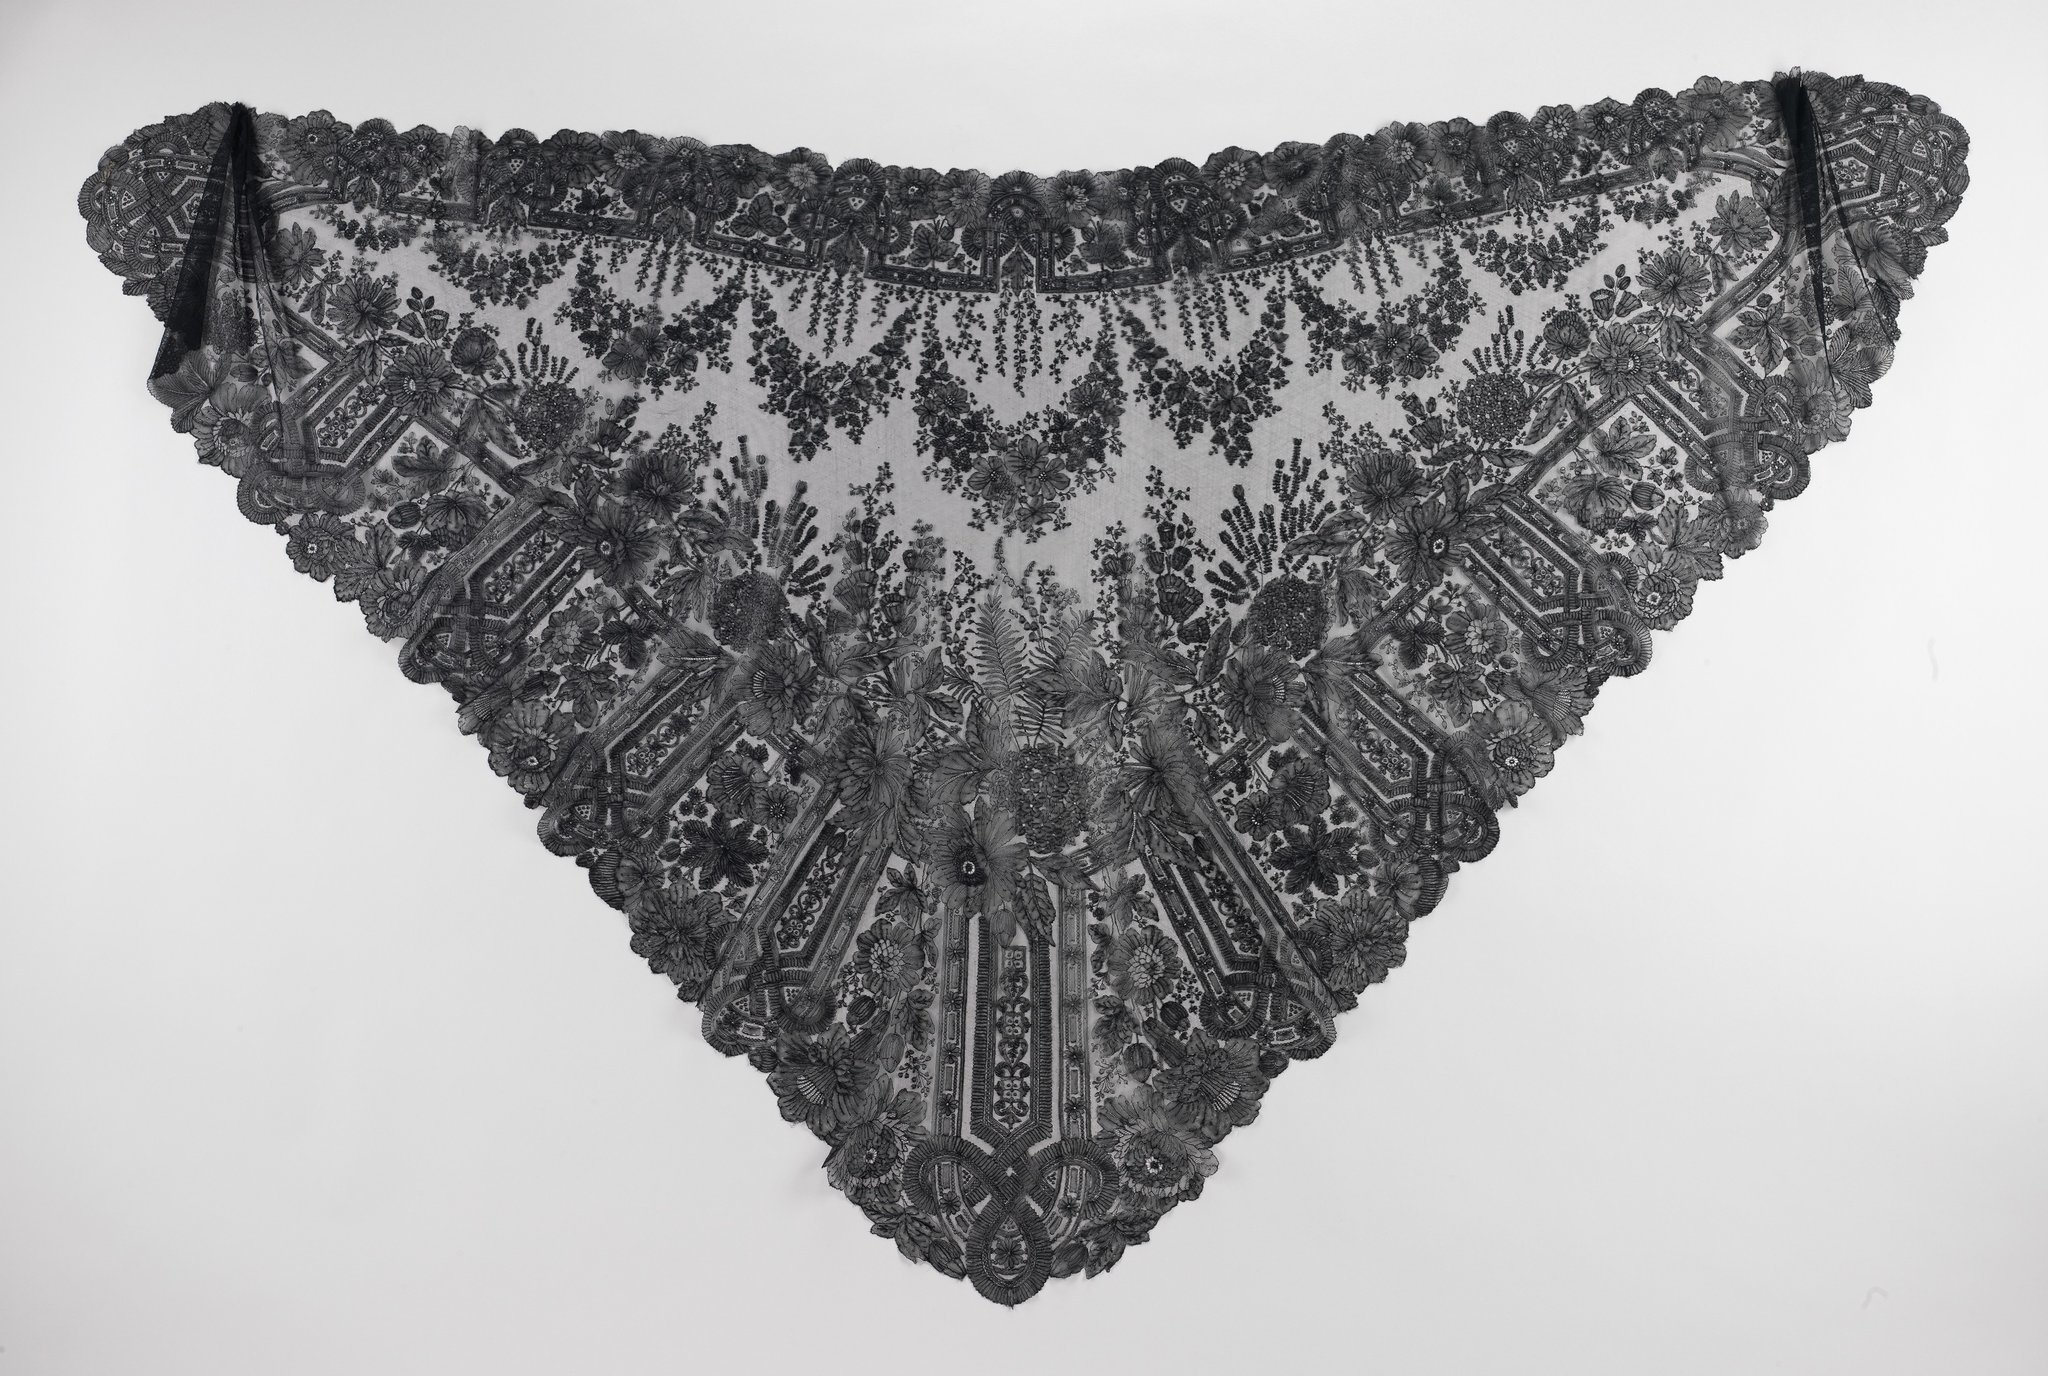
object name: shawl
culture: french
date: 1860-1870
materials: silk